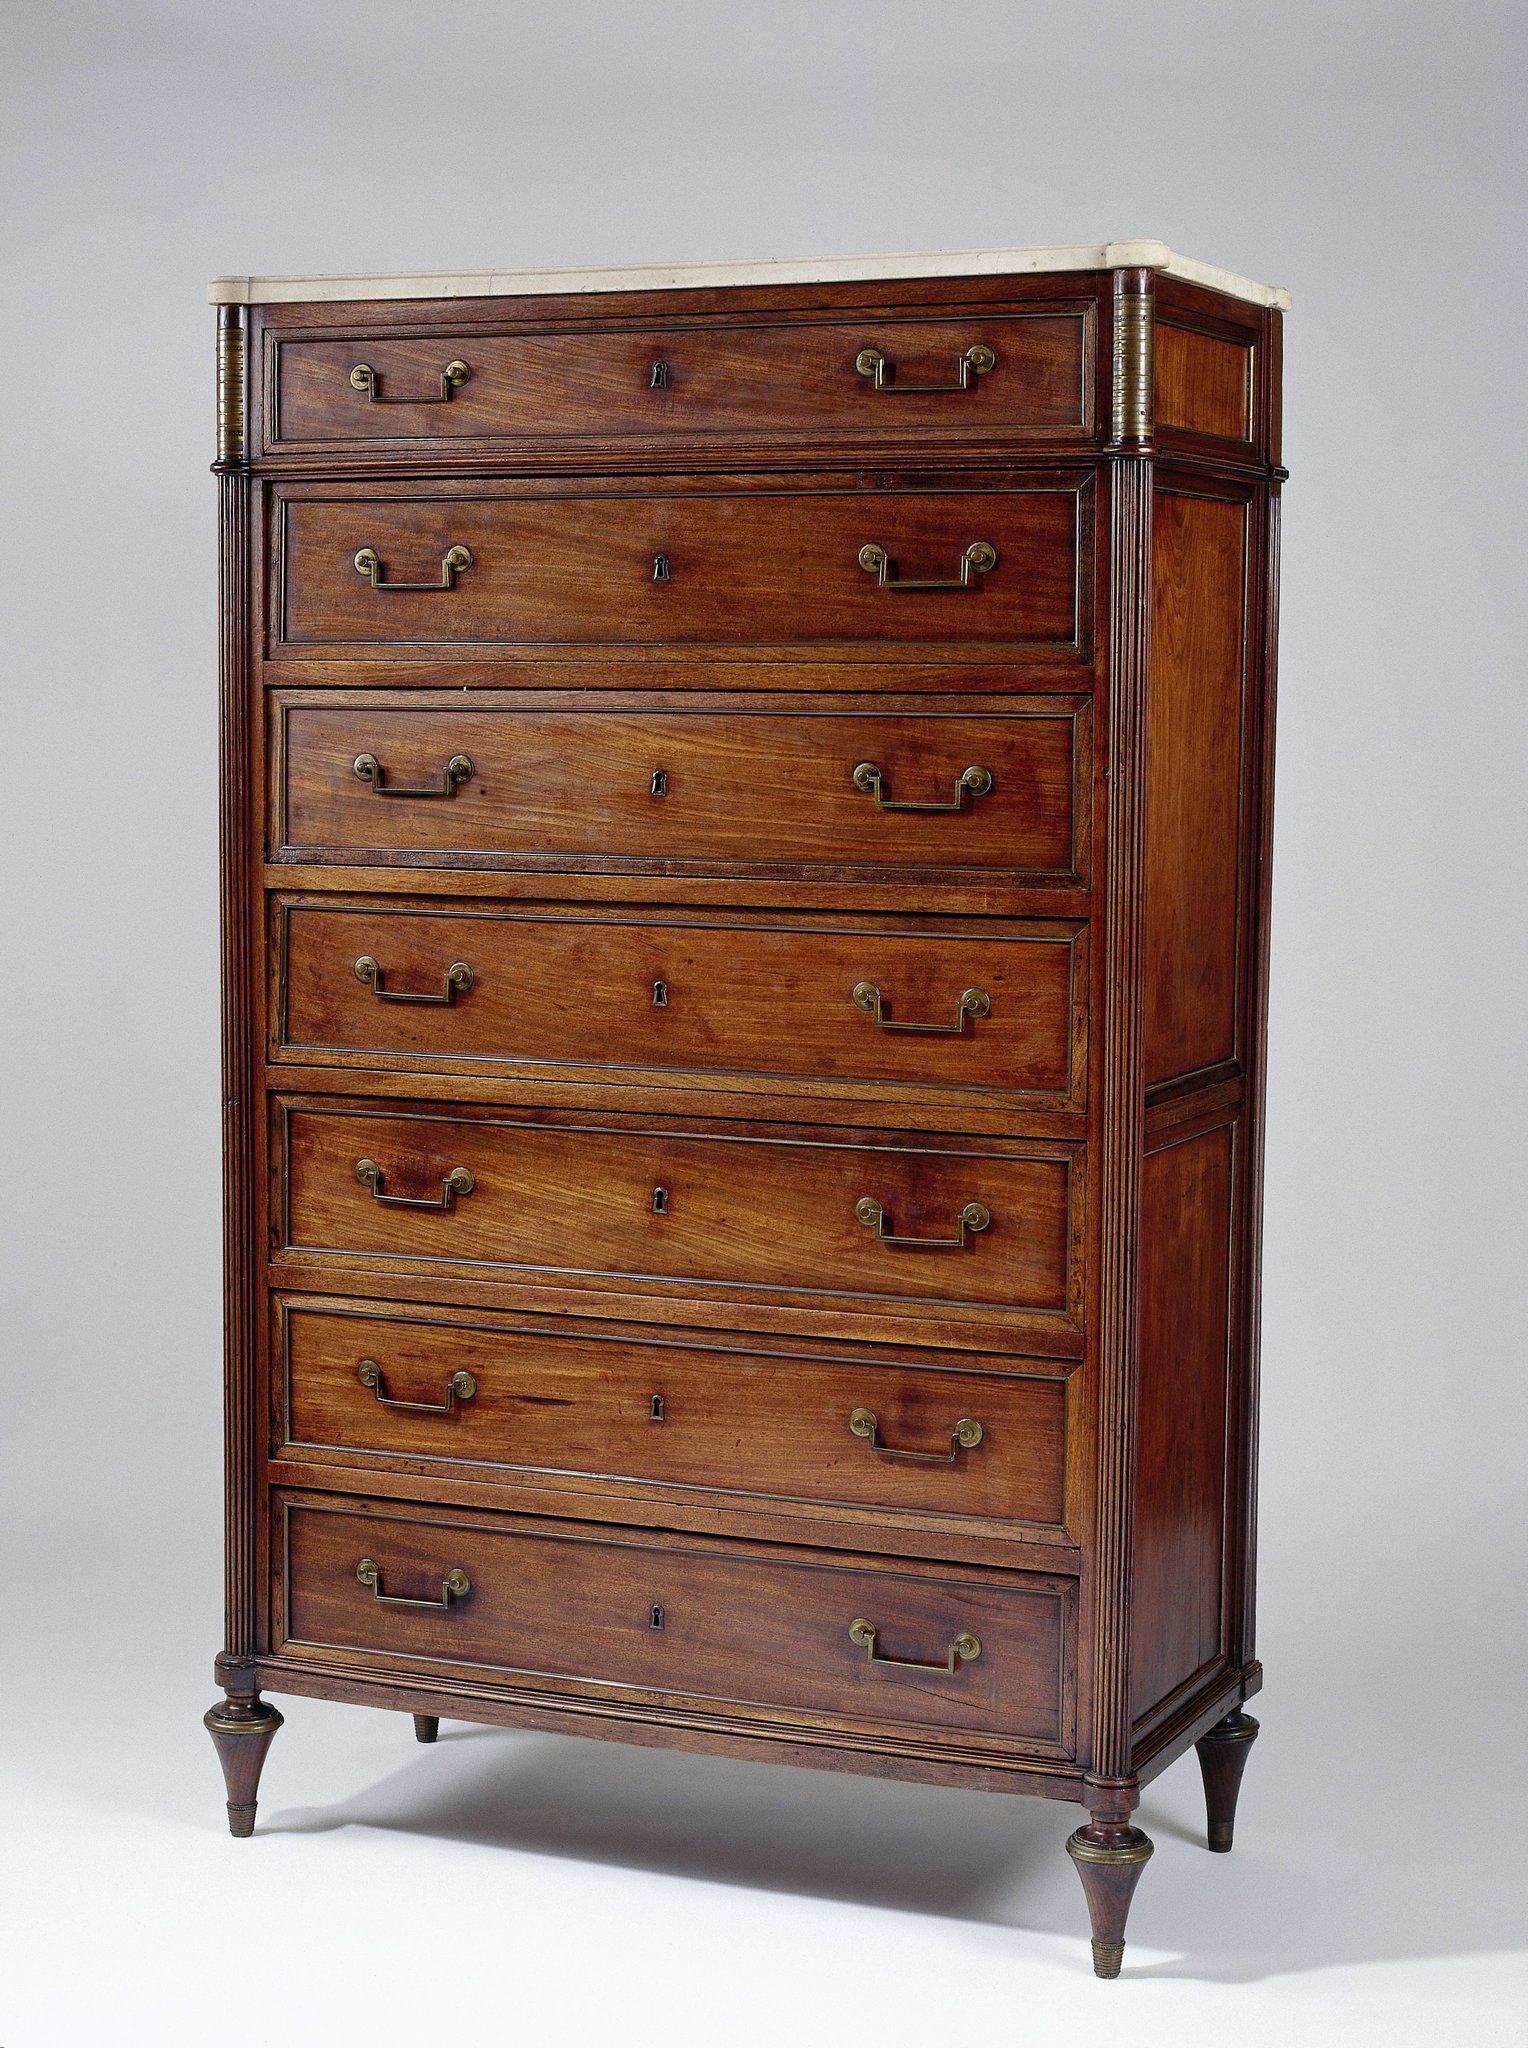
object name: chiffonnière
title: Chiffonnière (ladenkast) met zeven laden en blad van wit marmer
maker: bernard molitor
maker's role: furniture worker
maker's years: 1755-1833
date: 1790-1795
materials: copper, wood, marble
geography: paris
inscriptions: mark: ‘B.MOLITOR’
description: Chiffonnière (ladenkast) van eikenhout, belijmd met mahoniehout, beslag van koper, blad van wit marmer. Het rechthoekige meubel heeft zeven boven elkaar geplaatste grote laden met verdiepte velden, omgeven door koperen profielen, en rechthoekige koperen trekkers. Het heeft ronde, gecanneleerde stijlen op de voorste hoeken en gecanneleerde pilasters op de achterste hoeken. Het rust op tolvormige poten. Onder de bovenste lade wordt het geleed door een rondlopend profiel. De hoekstijlen zijn boven dit profiel voorzien van koperen platen met een versiering van horizontale lijnen en geometrische motieven; de pilasters zijn op deze hoogte niet gecanneleerd. De zijkanten vertonen elk drie verdiepte velden